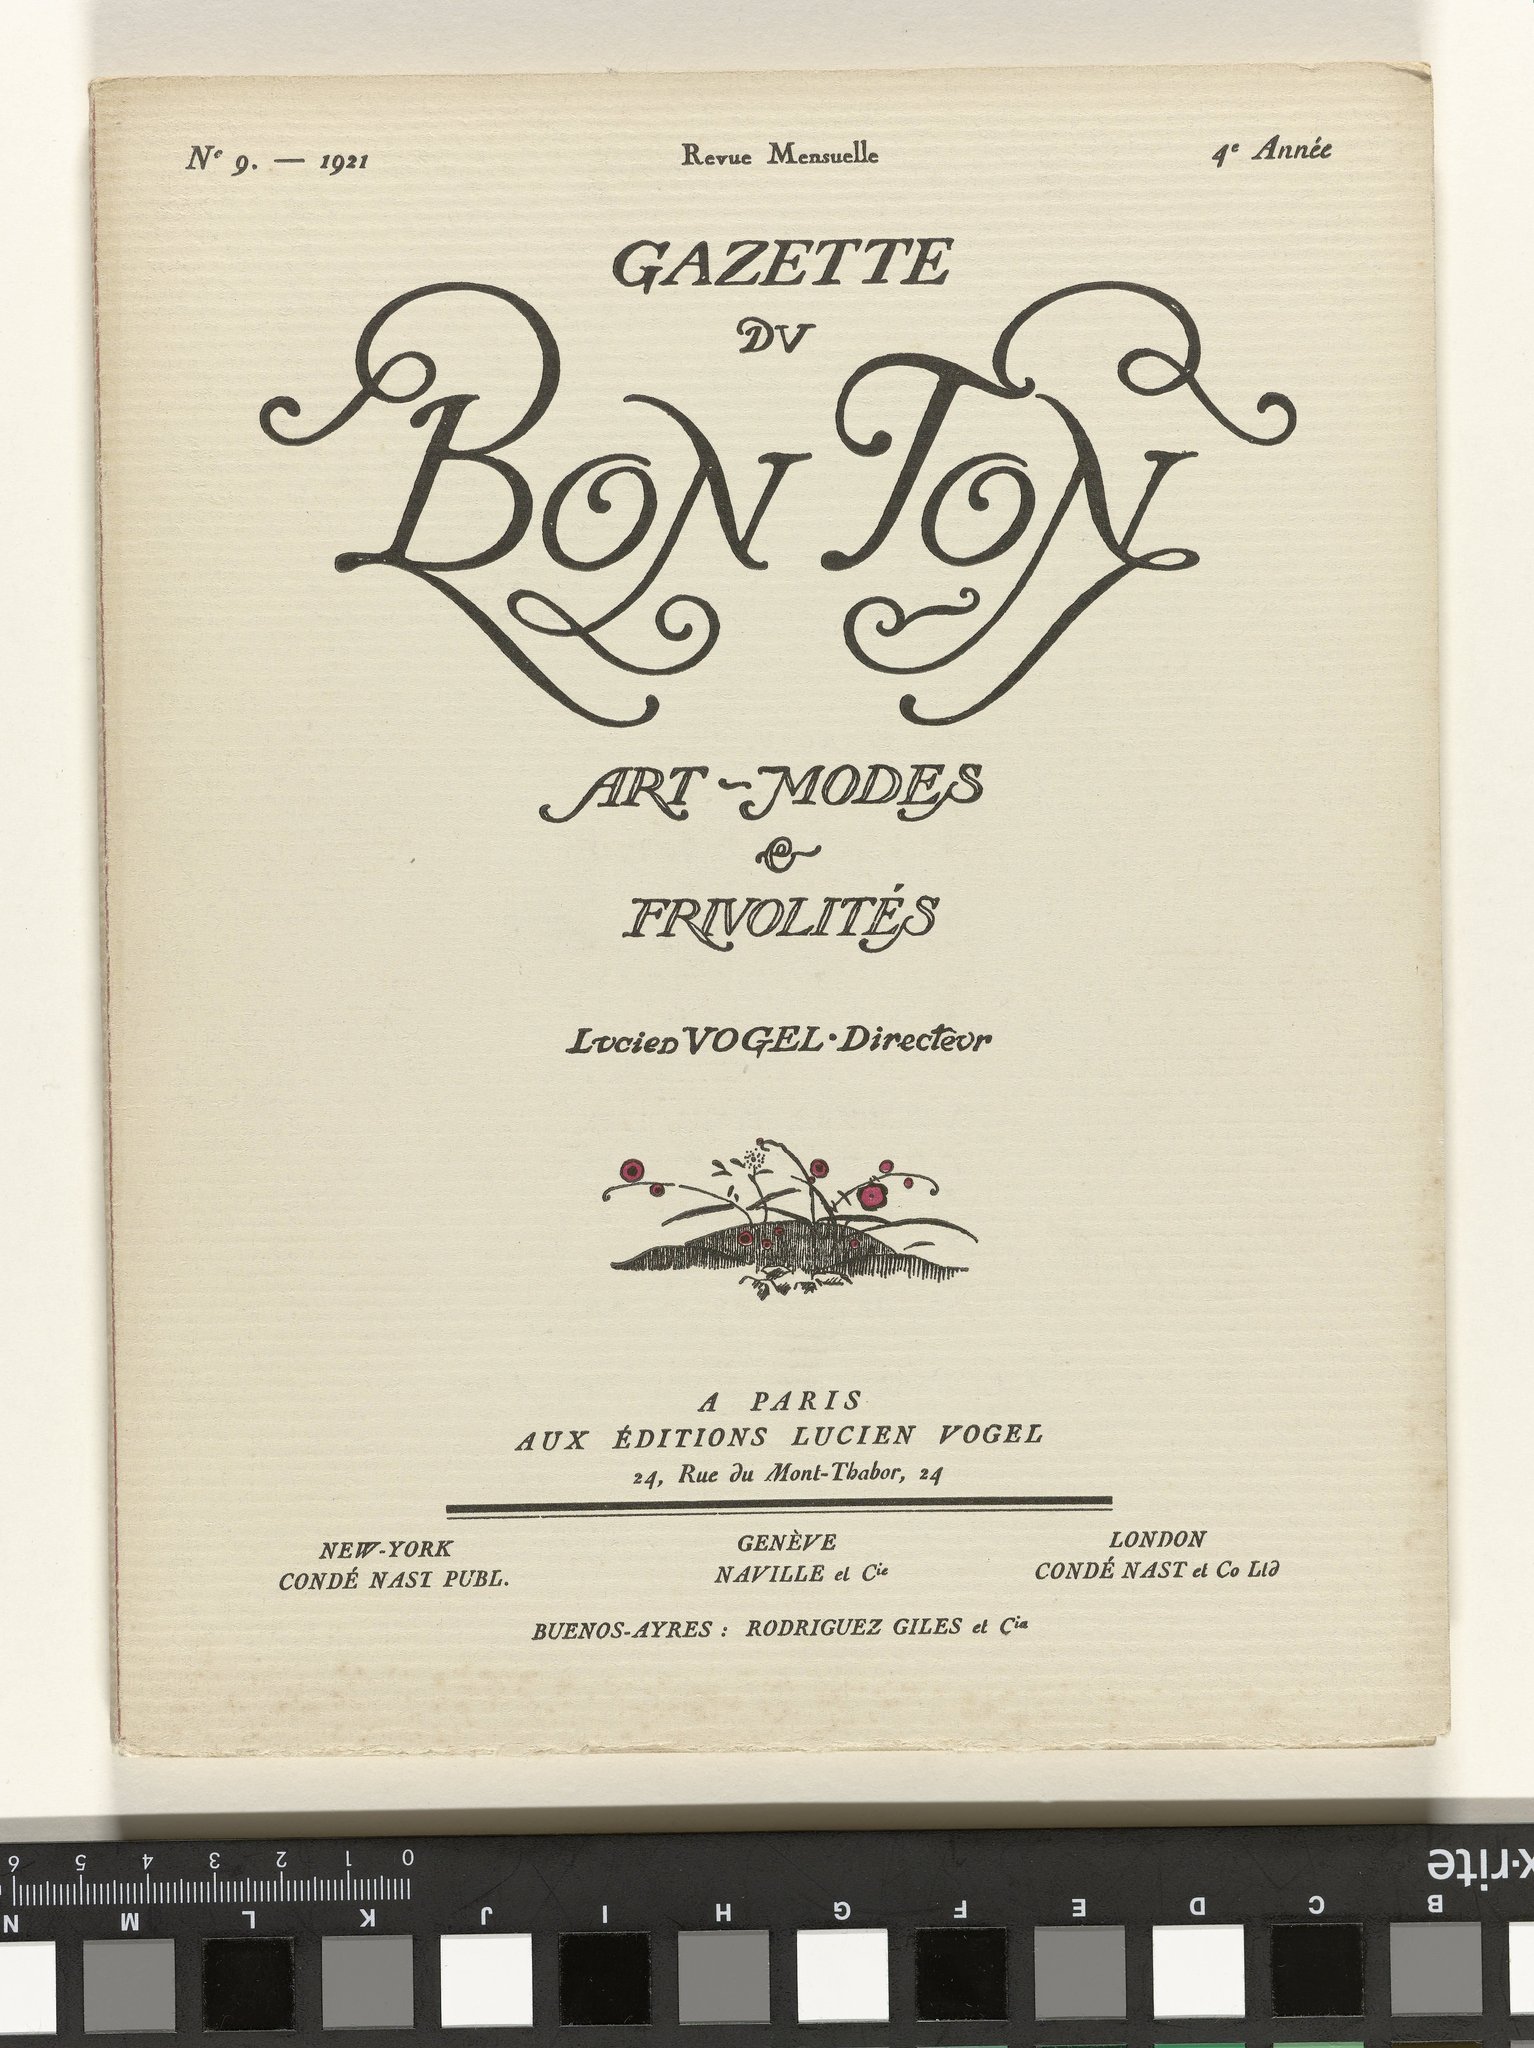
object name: magazine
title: Gazette du Bon Ton. Art - Modes & Frivolités, No. 9 - 1921, 4e Année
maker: lucien vogel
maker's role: publisher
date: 1921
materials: paper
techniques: letterpress printing, pochoir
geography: buenos aires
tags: fashion plates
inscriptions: date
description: Aflevering no. 9, november 1921, van Gazette du Bon Ton, bestaand uit een omslag, acht katernen met tekst en illustraties en acht losse prenten. Aan dit deel werkten de volgende modeontwerpers mee: Beer, Doeuillet, Lanvin, Paul Poiret, Camille Roger, Vionnet en Worth.